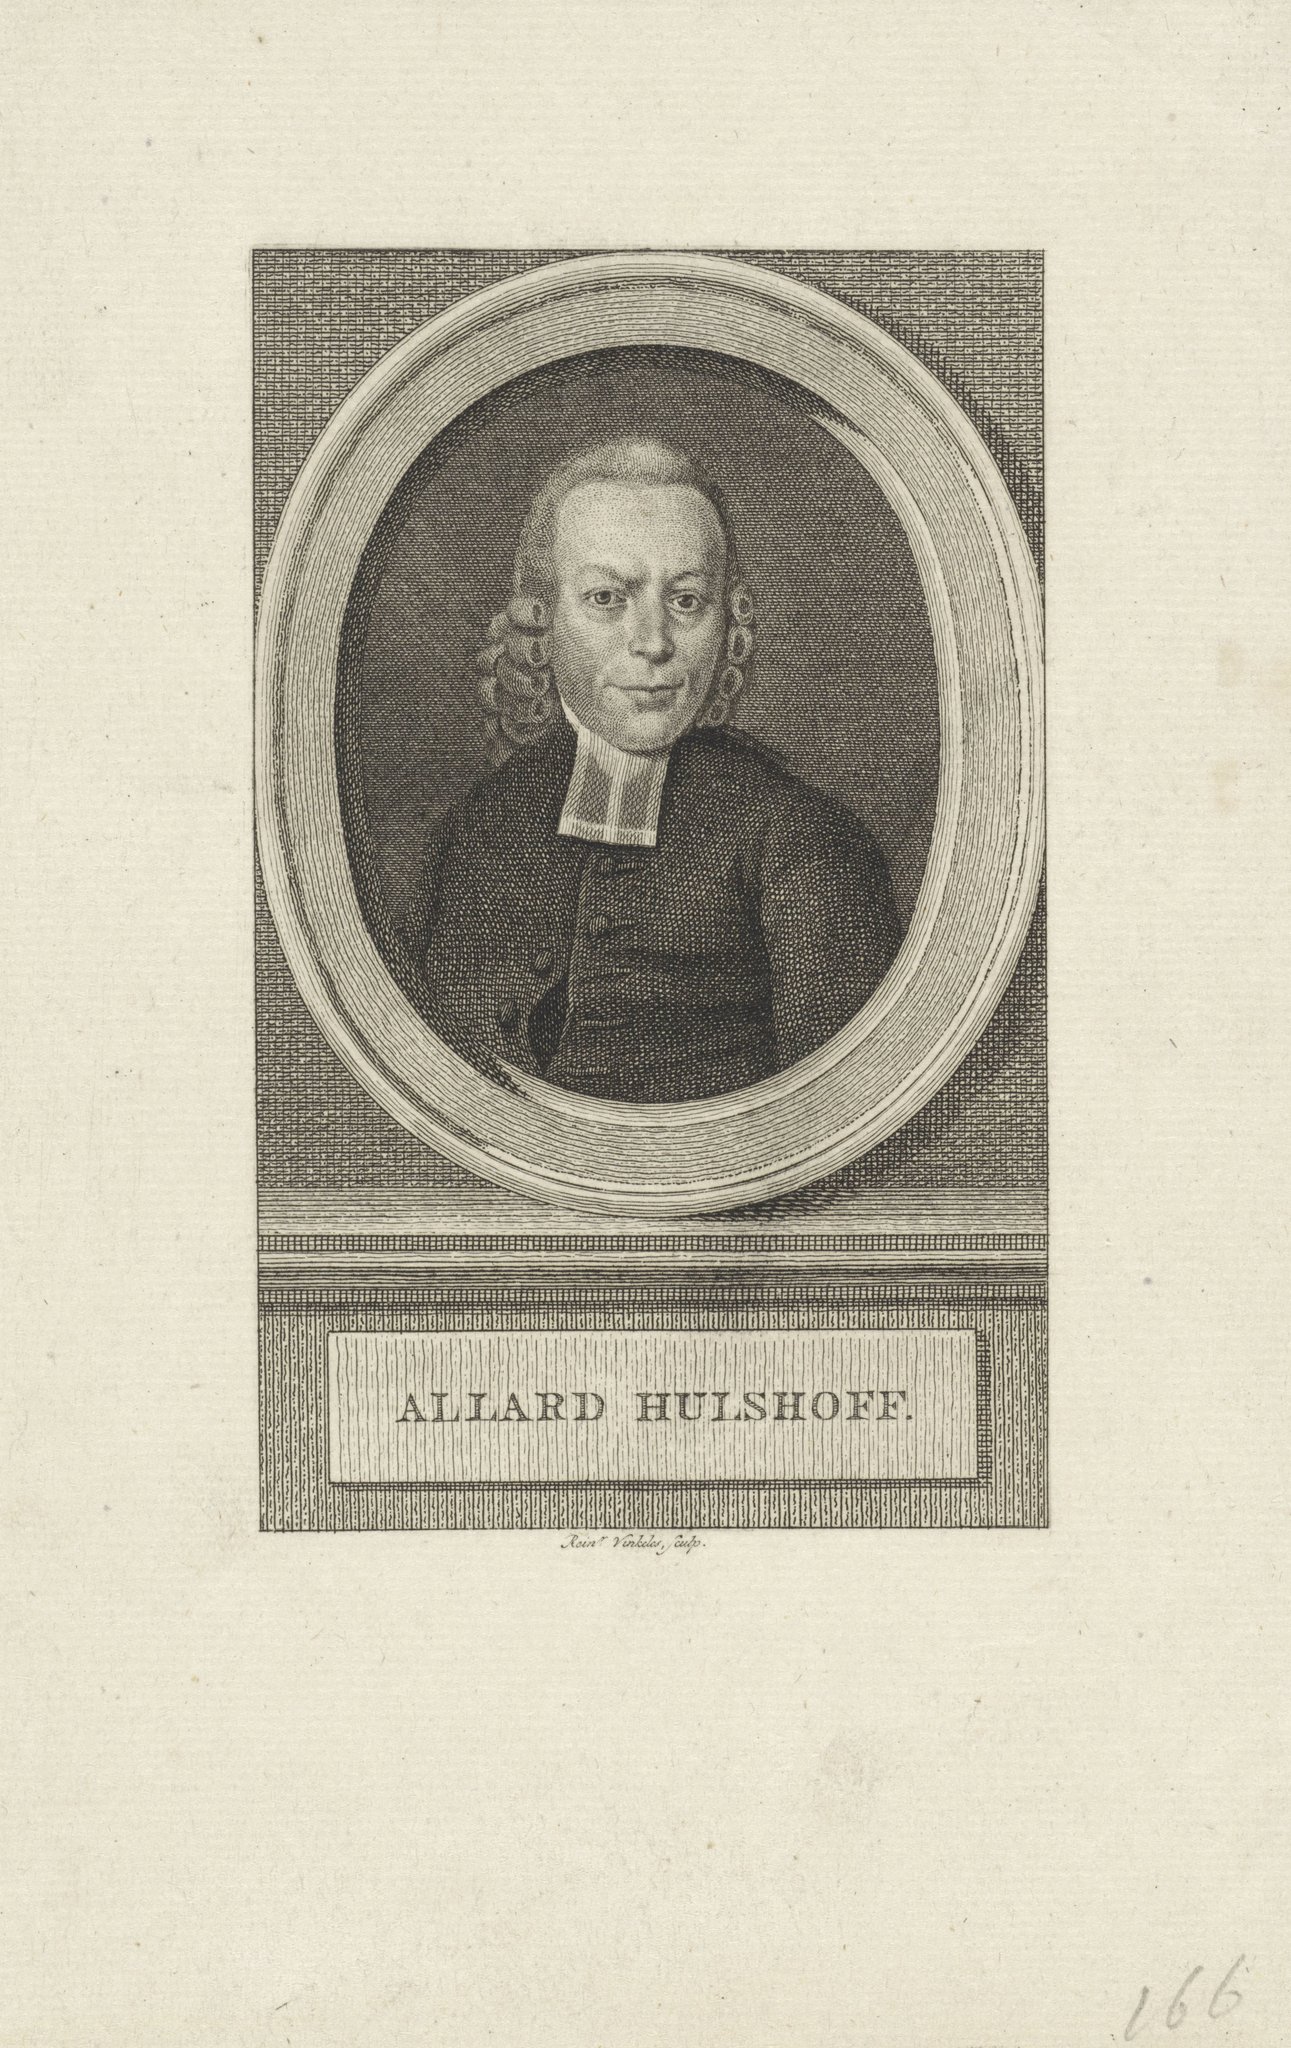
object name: print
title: Portret van Allard Hulshoff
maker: reinier vinkeles (i)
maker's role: draughtsman, print maker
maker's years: 1741-1816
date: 1786-1809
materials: paper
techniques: engraving, etching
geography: amsterdam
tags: amsterdam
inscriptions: collector's mark: Lugt 2228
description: Prent ook gebruikt als boekillustratie in: Wagenaar, Jan. Vaderlandsche historie, (...) ten vervolge van Wagenaars Vaderlandsche historie. Dl. 1-43. Amsterdam: Johannes Allart, 1786-1809.